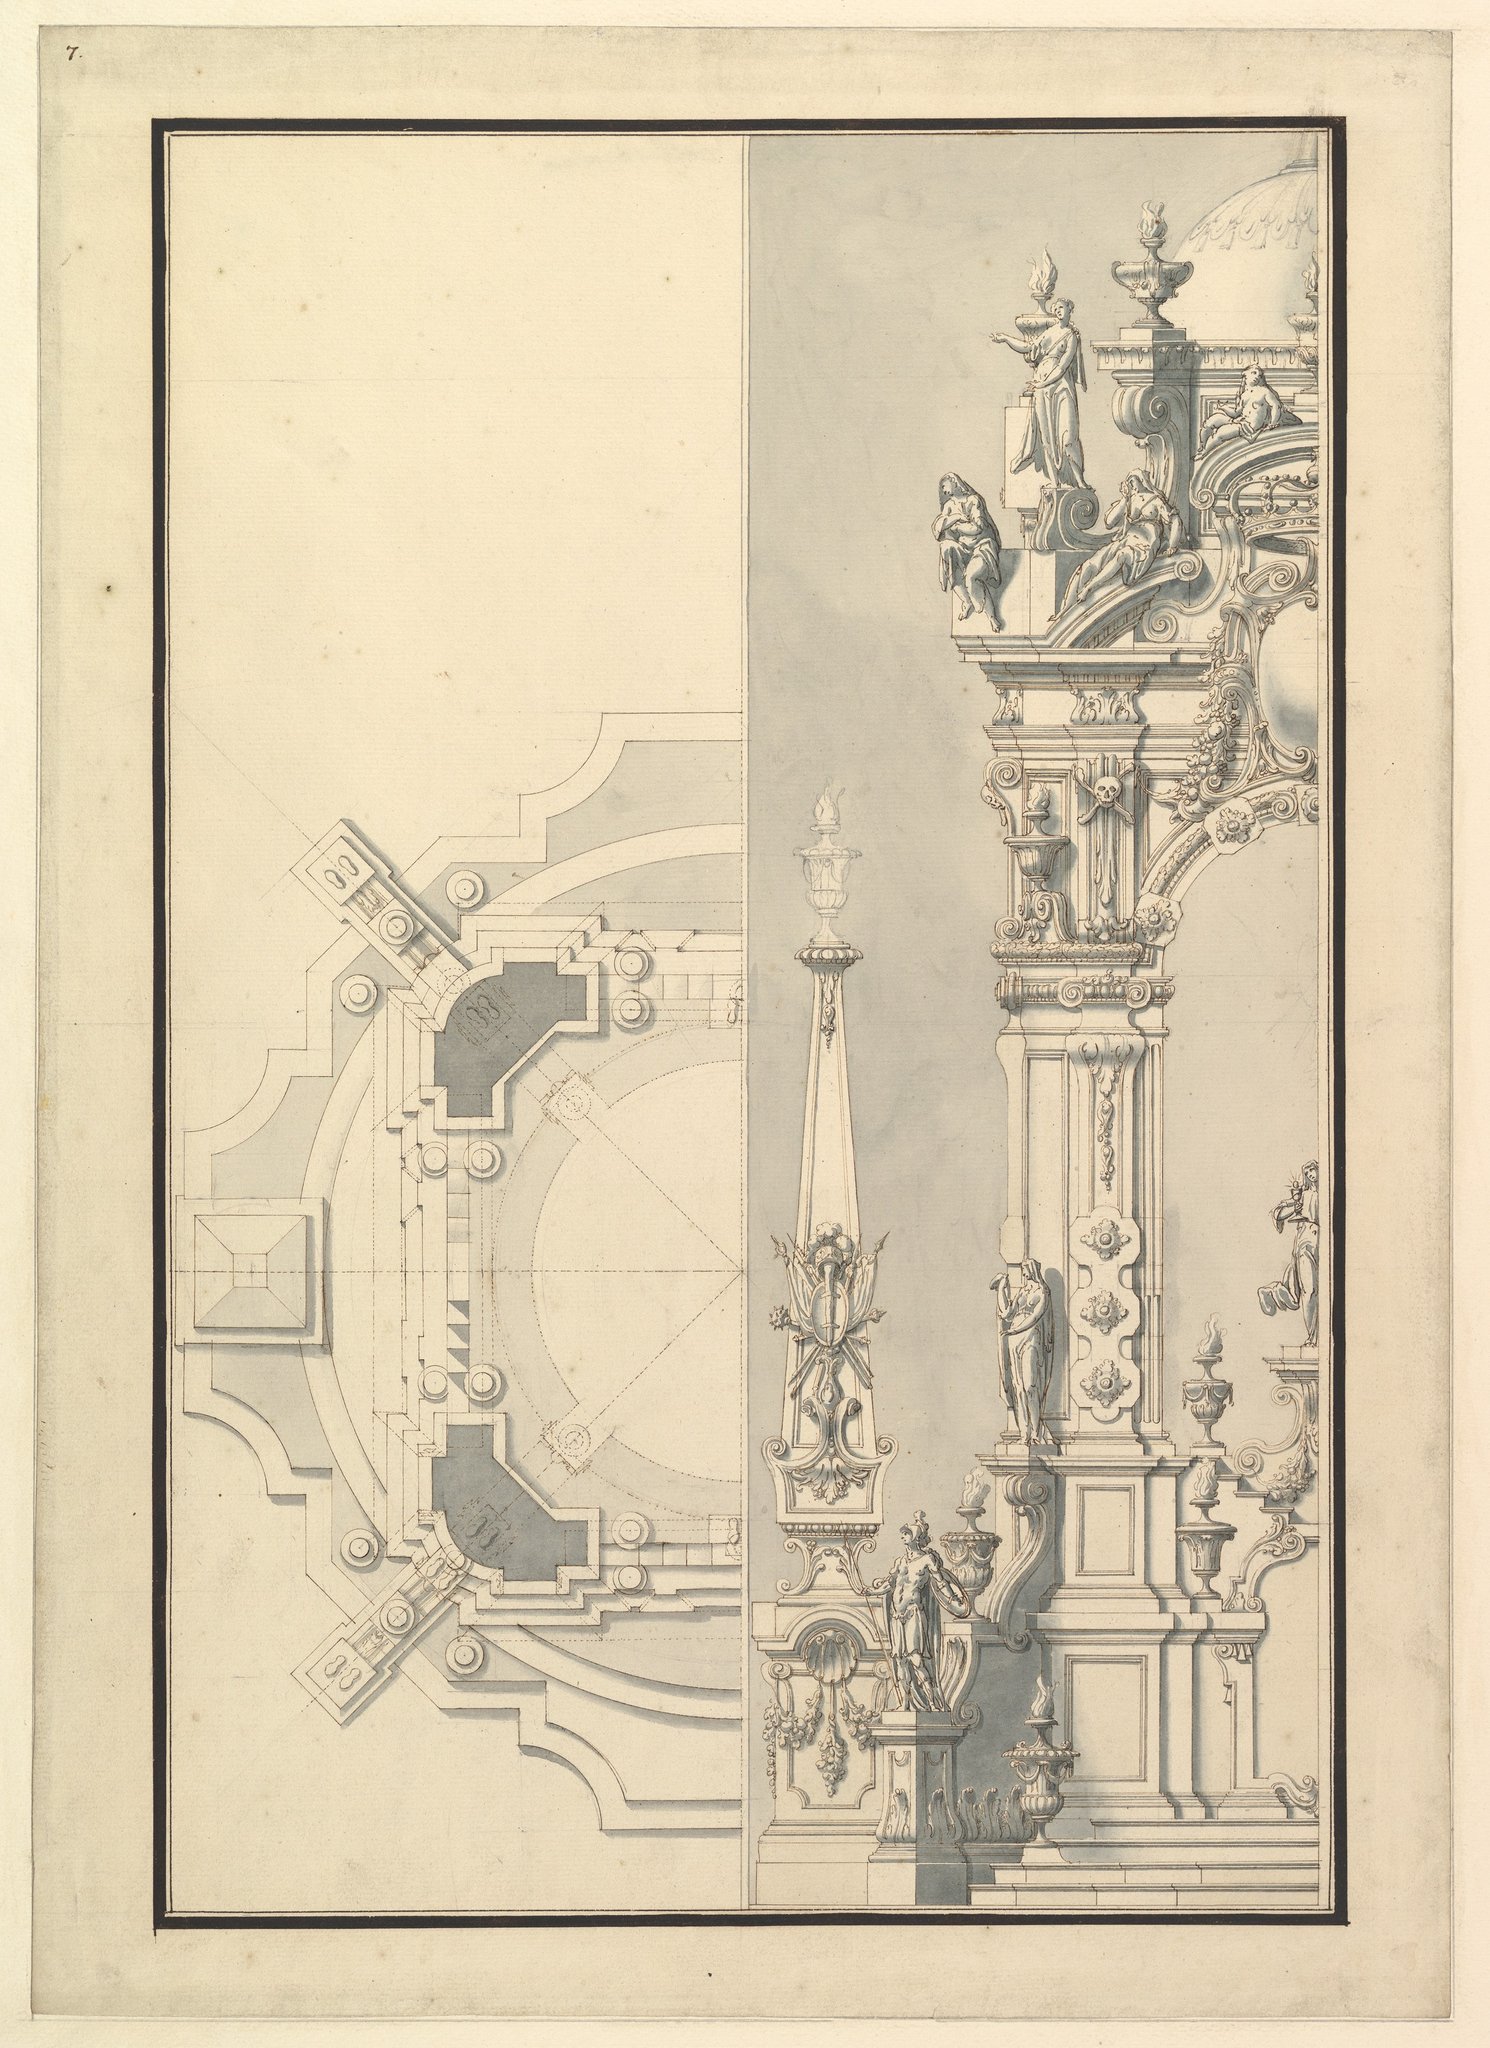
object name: drawing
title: Half Elevation and Half Ground Plan for a Catafalque for an Electress Palatine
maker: giuseppe galli bibiena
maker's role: artist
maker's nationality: italian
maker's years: 1696-1756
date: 1696-1756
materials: ink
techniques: pen, wash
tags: architecture